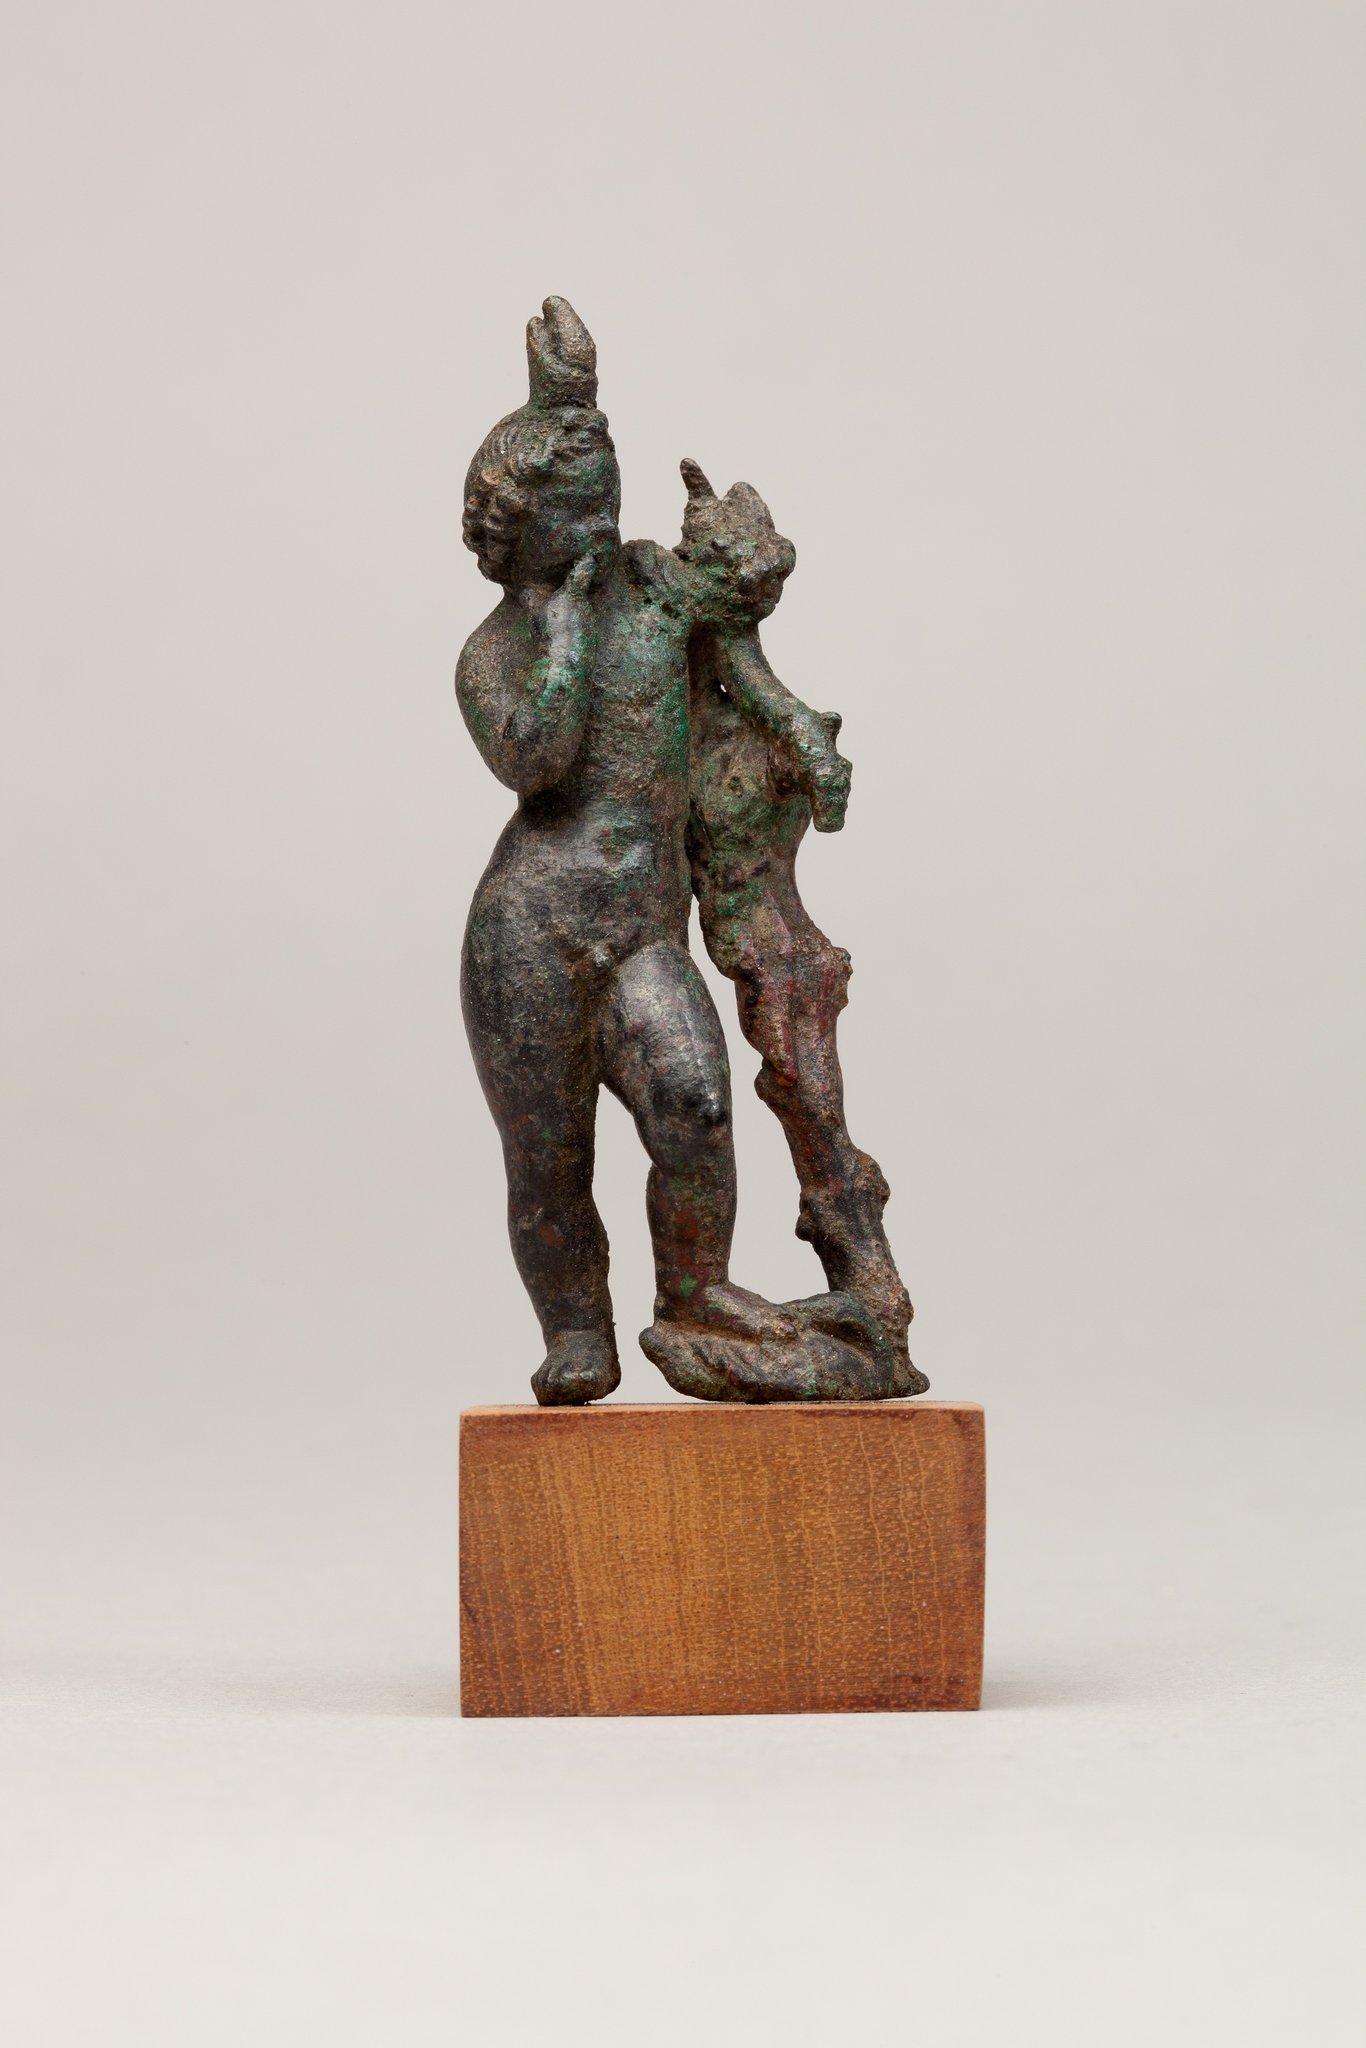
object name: statuette, harpokrates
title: Statuette representing Harpokrates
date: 332 BCE-200 CE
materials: copper alloy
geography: egypt